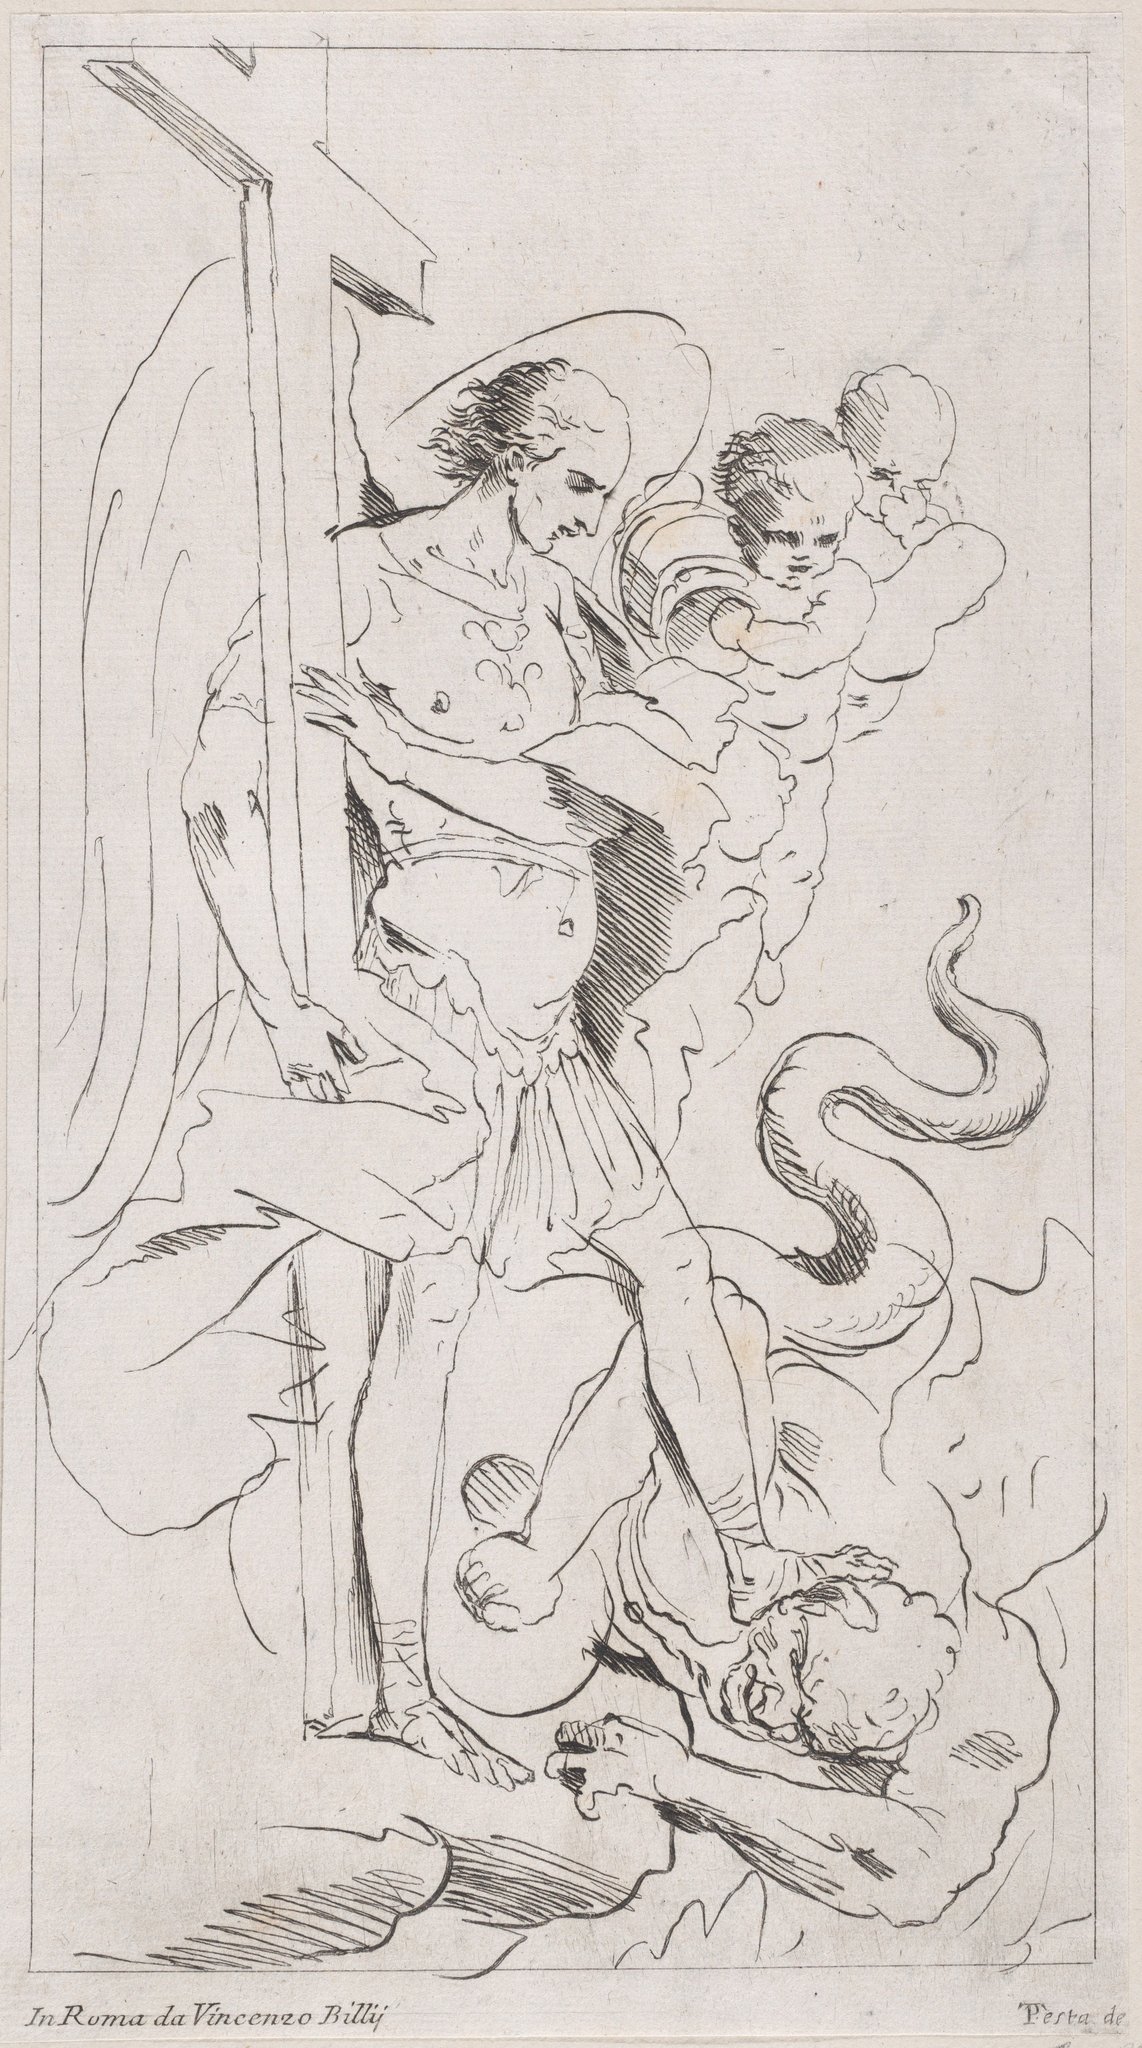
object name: print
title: Saint Michael the Archangel crushing the demon underfoot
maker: anonymous, 18th century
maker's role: artist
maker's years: 1700-1800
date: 1700-1800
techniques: etching